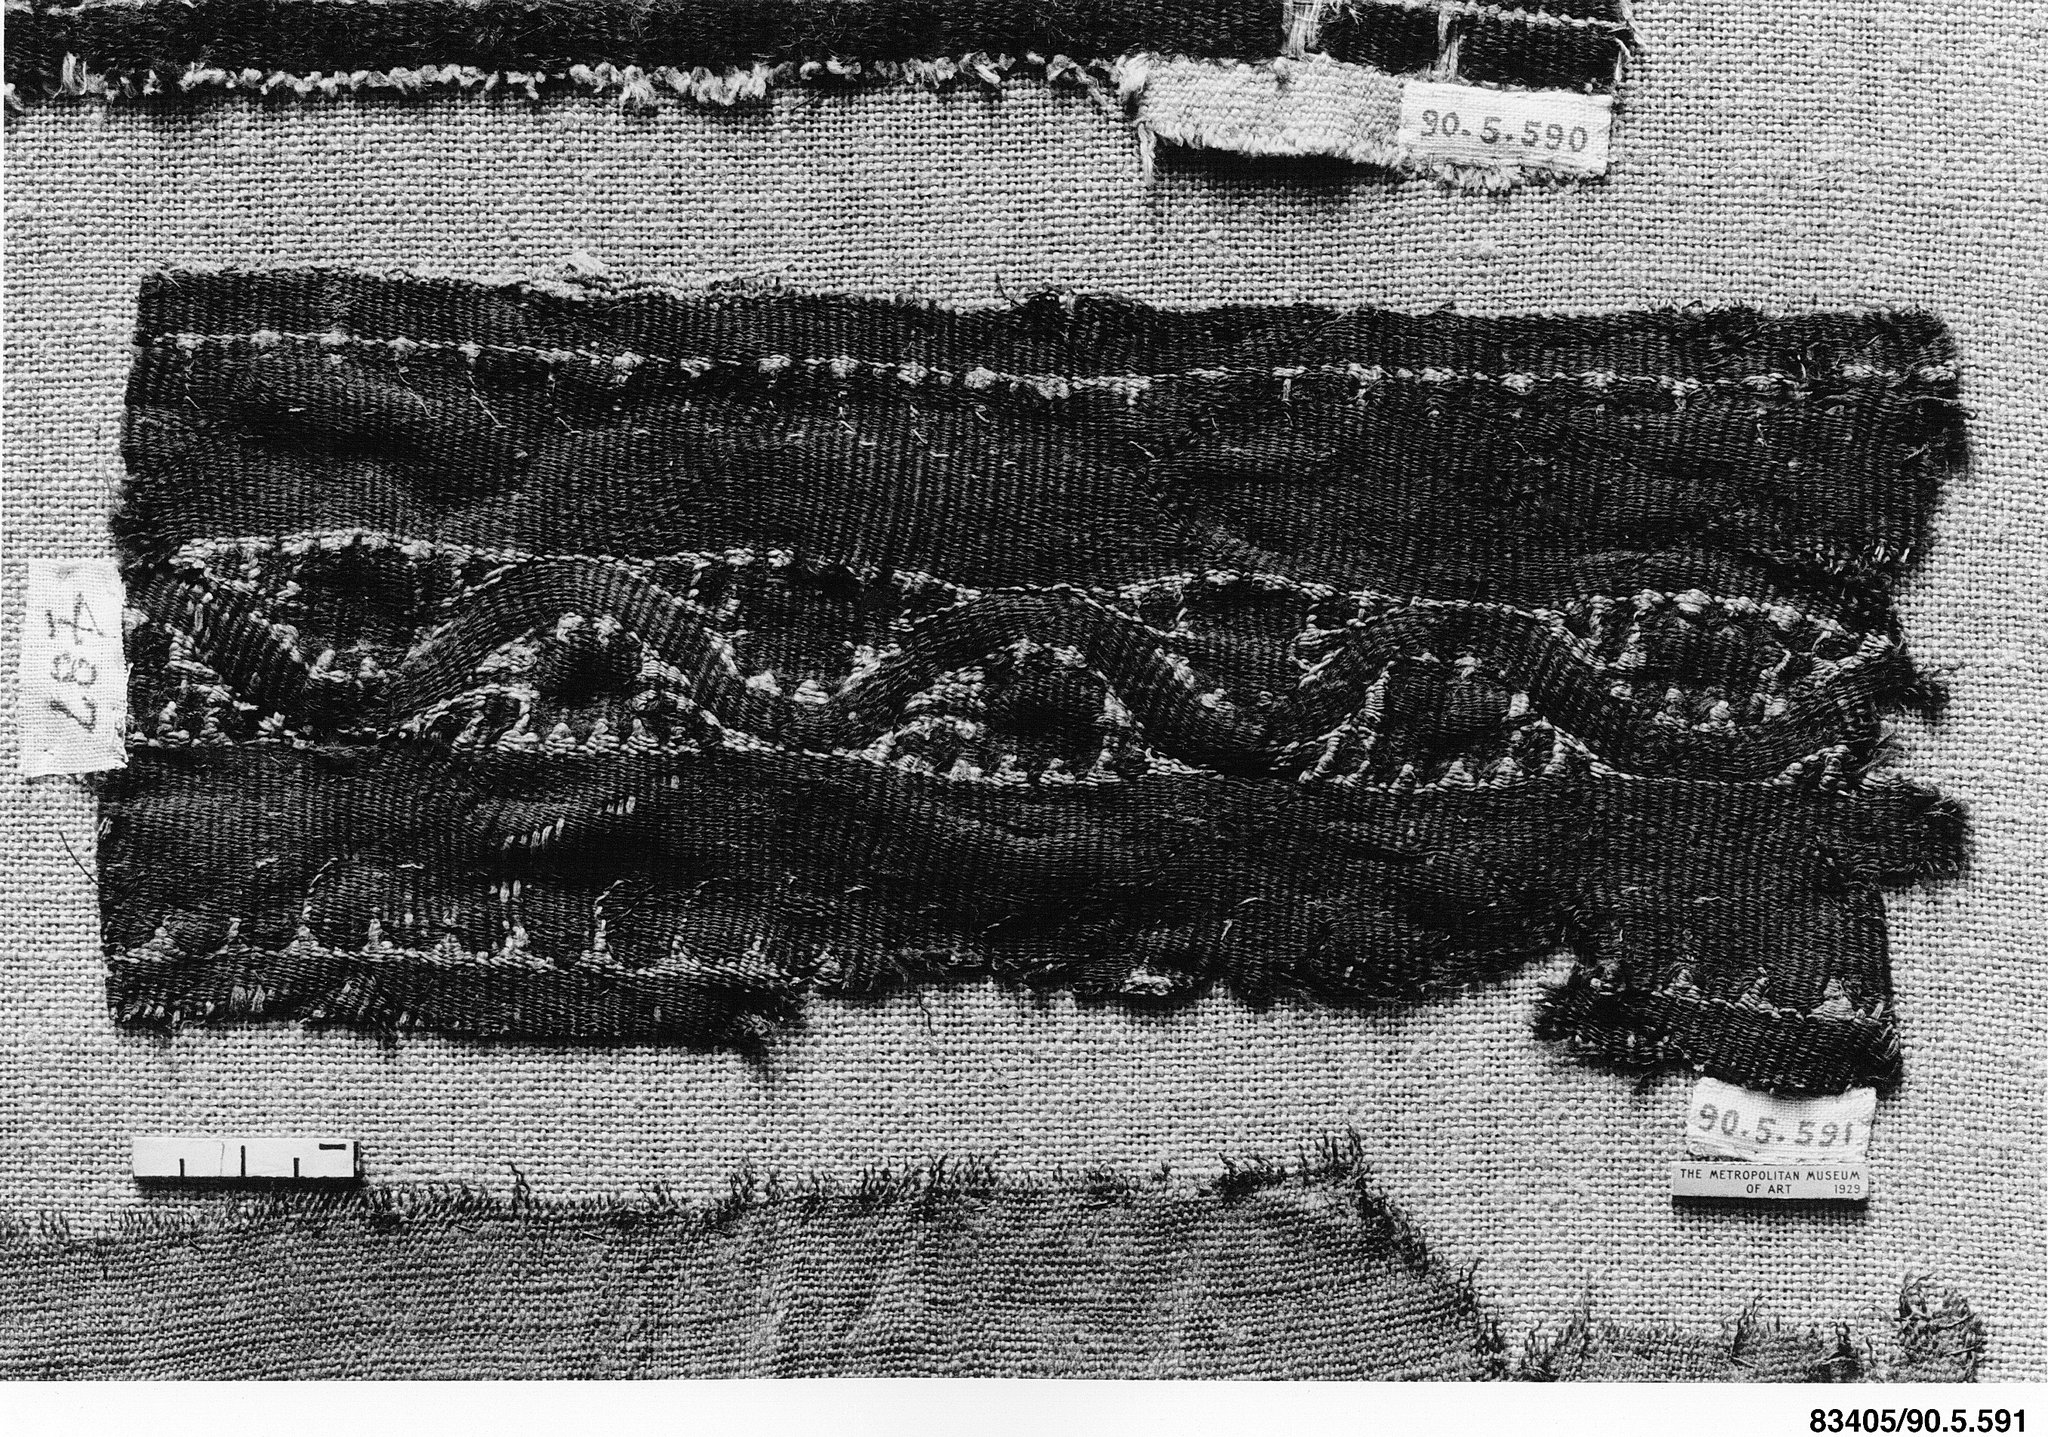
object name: textile fragment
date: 201-400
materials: linen, wool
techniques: weave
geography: egypt